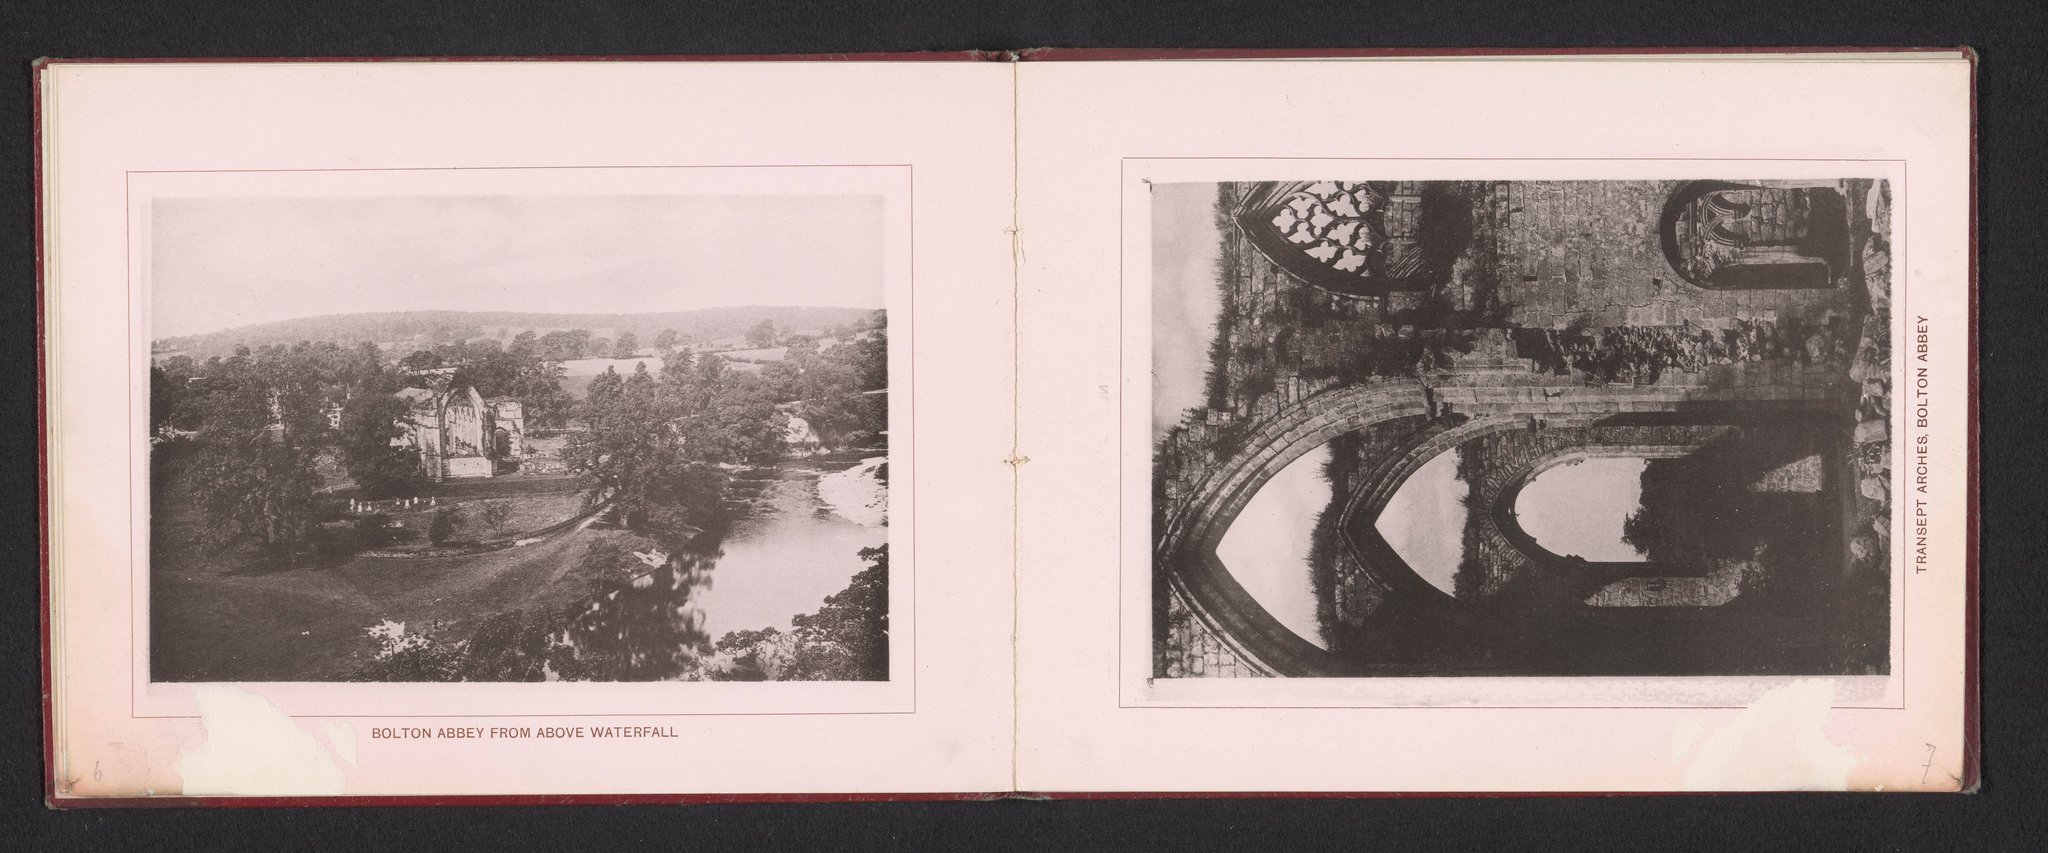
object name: page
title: Transept arches, Bolton Abbey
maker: Anonymous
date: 1890-1900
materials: linen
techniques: photograph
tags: arch, archivolt ~ architecture, ruin of church, monastery, etc.